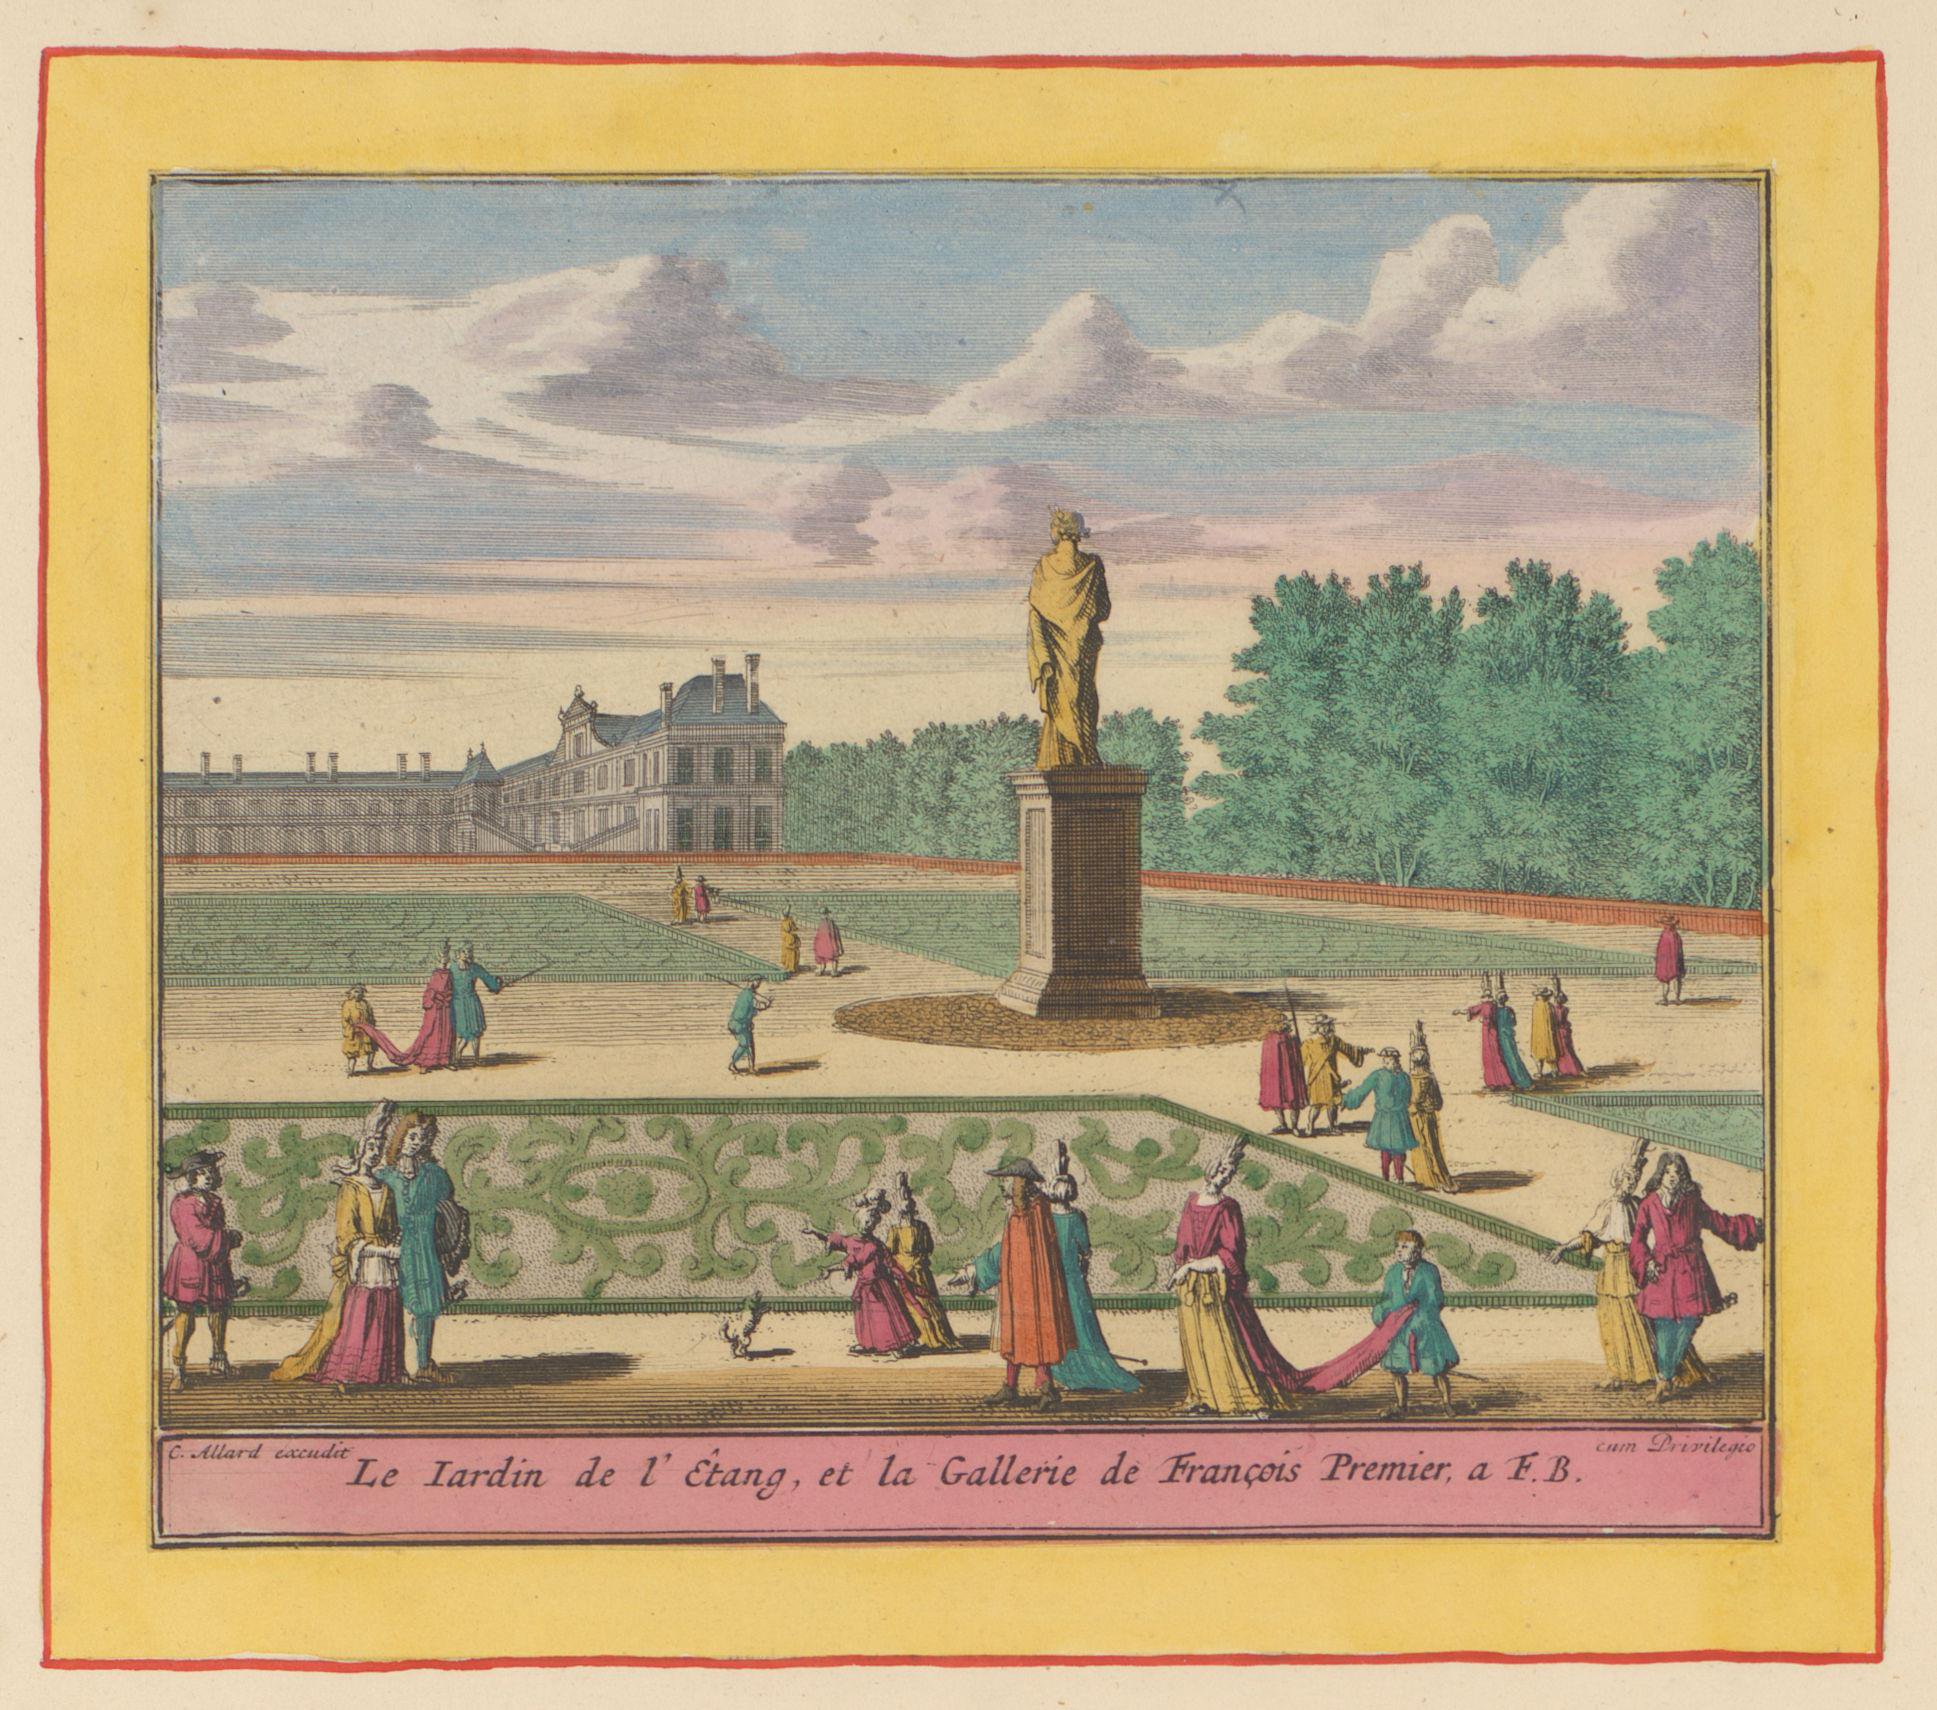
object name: print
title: Gezichten op het paleis van Fontainebleau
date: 1684-1709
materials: paper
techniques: etching, hand coloring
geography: amsterdam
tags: palace, french or architectonic garden; formal garden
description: De tuin en de Galerie François I van het paleis van Fontainebleau. Op een kruising van paden staat een tuinbeeld op een sokkel, rondom wandelen figuren. Prent maakt deel uit van een album.